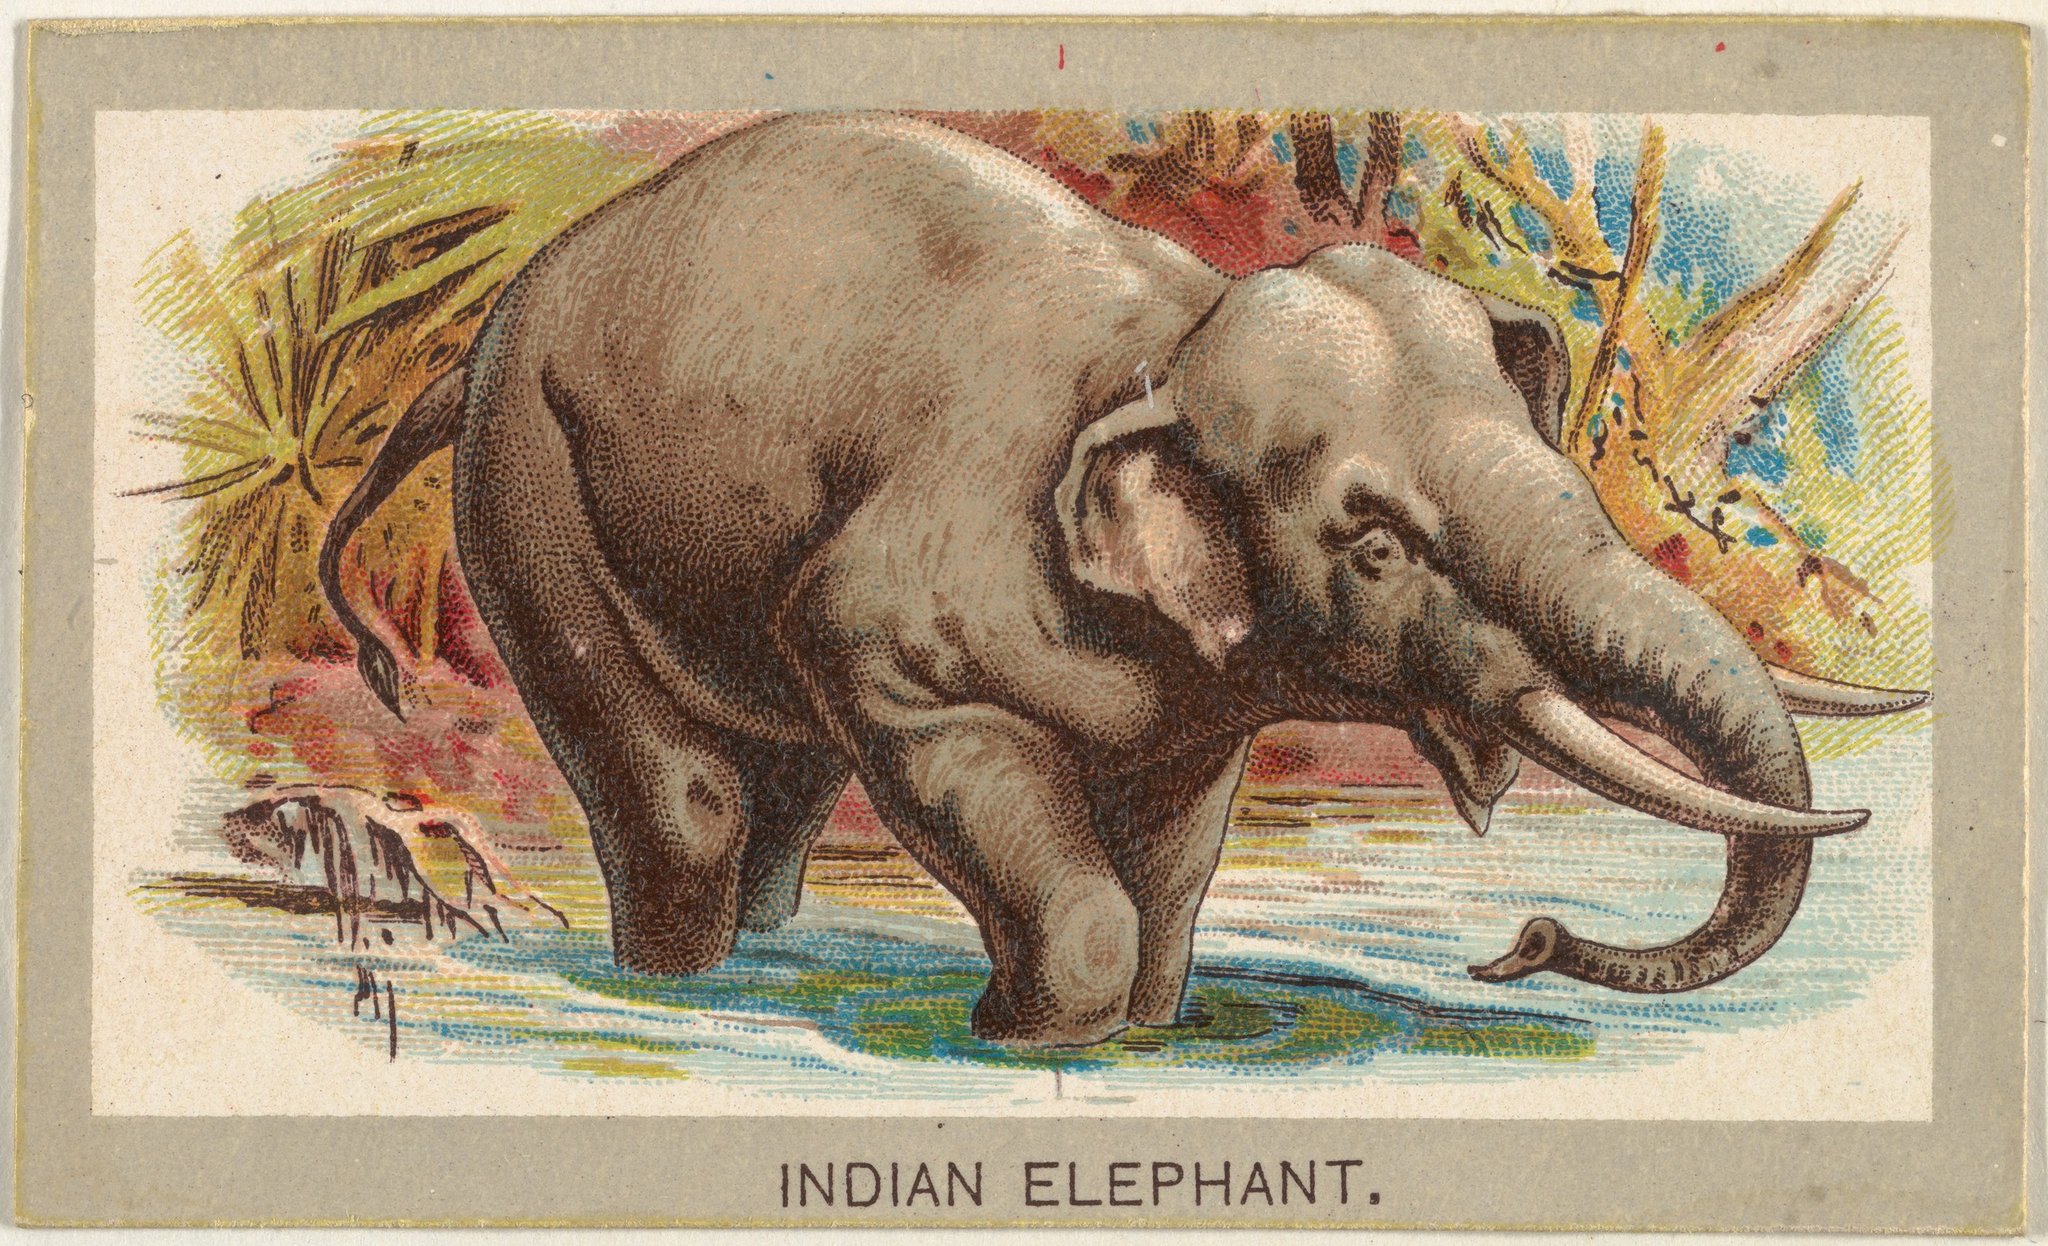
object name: print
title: Indian Elephant, from the Animals of the World series (T180), issued by Abdul Cigarettes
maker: abdul cigarettes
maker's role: publisher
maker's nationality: american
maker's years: 1881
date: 1881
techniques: color lithograph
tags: elephants